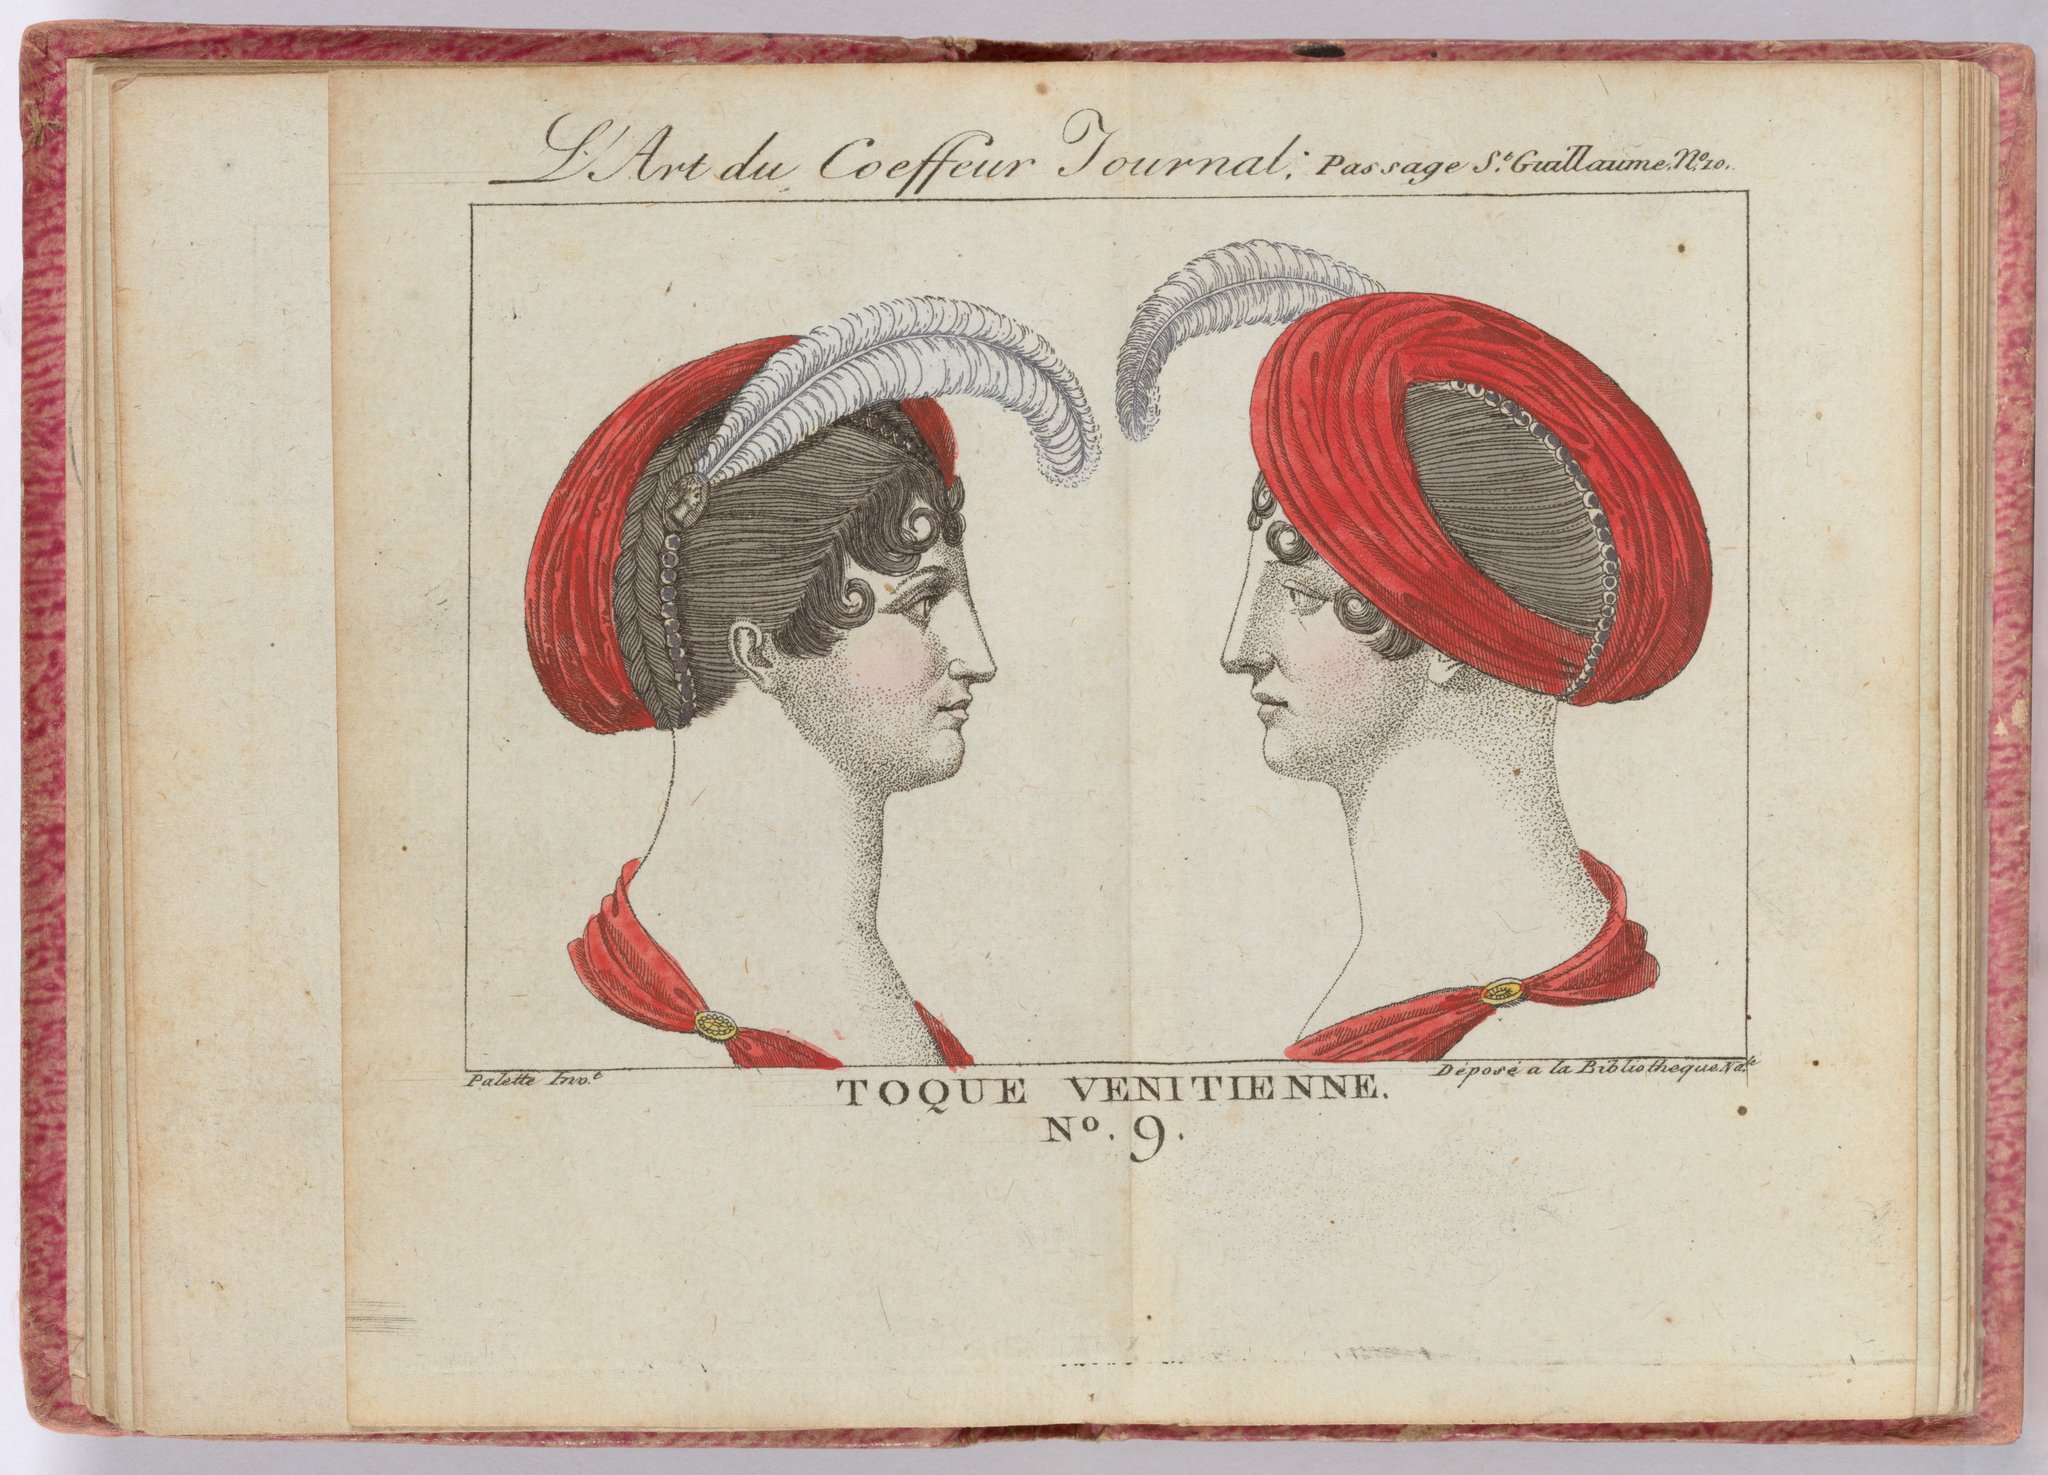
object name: book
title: L'Art de Coeffure, Journal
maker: j. n. palette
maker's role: designer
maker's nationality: french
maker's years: 18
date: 1803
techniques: engraving, hand coloring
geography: france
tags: hair